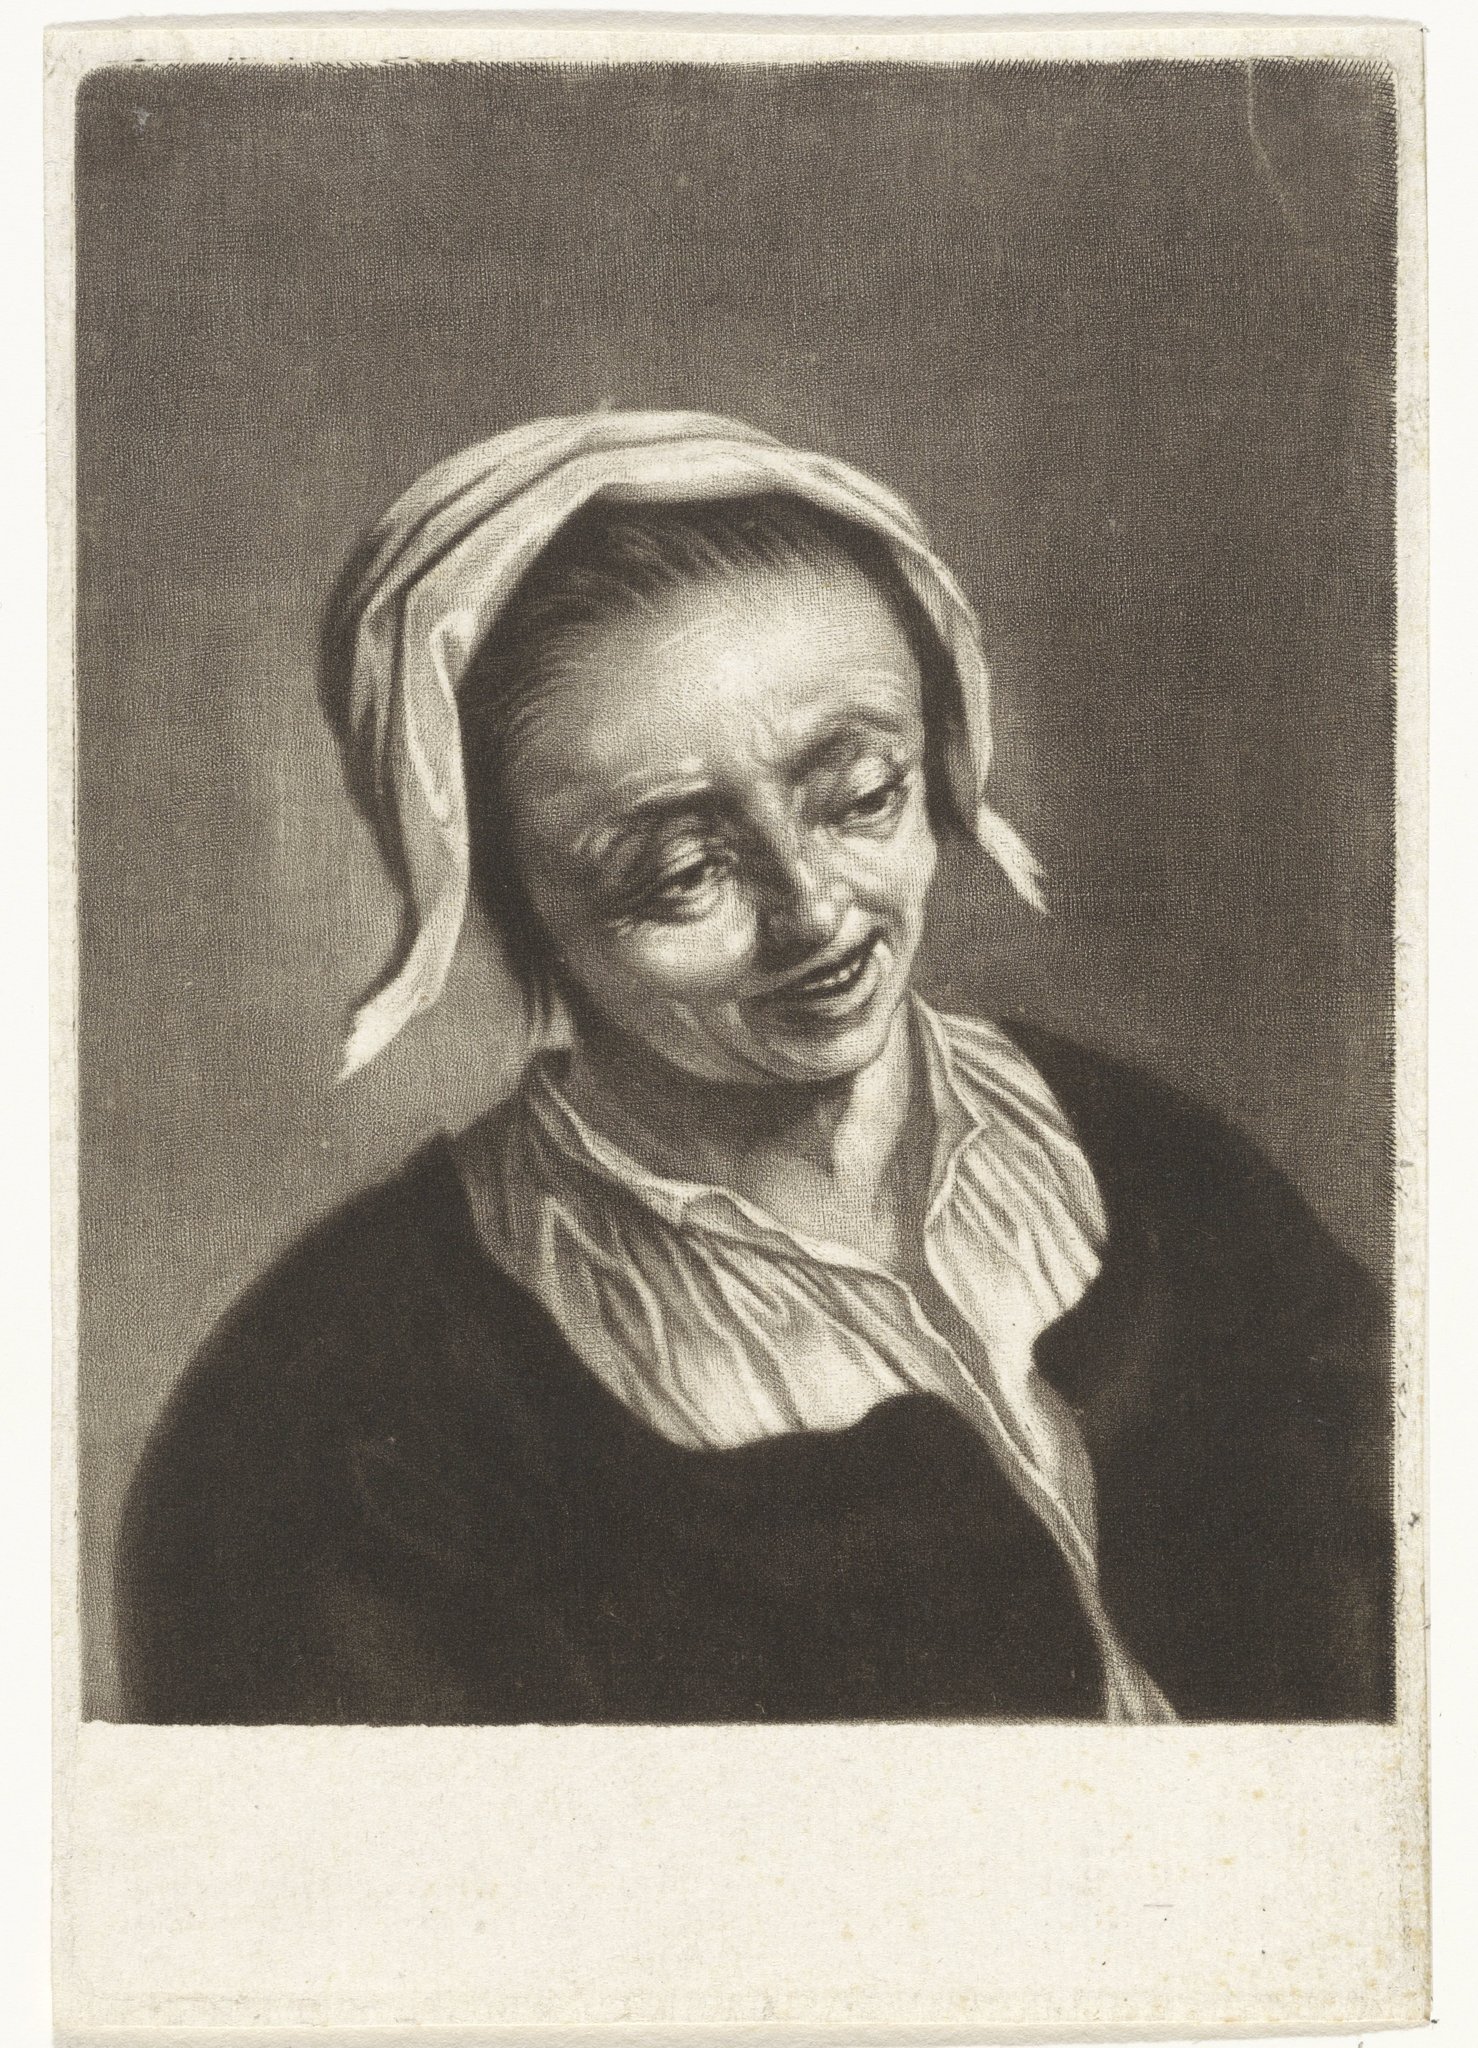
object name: print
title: Portret van de moeder van Adriaen en Isaac van Ostade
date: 1730-1790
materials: paper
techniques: mezzotint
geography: amsterdam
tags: mother and baby or young child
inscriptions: collector's mark: Lugt 2228